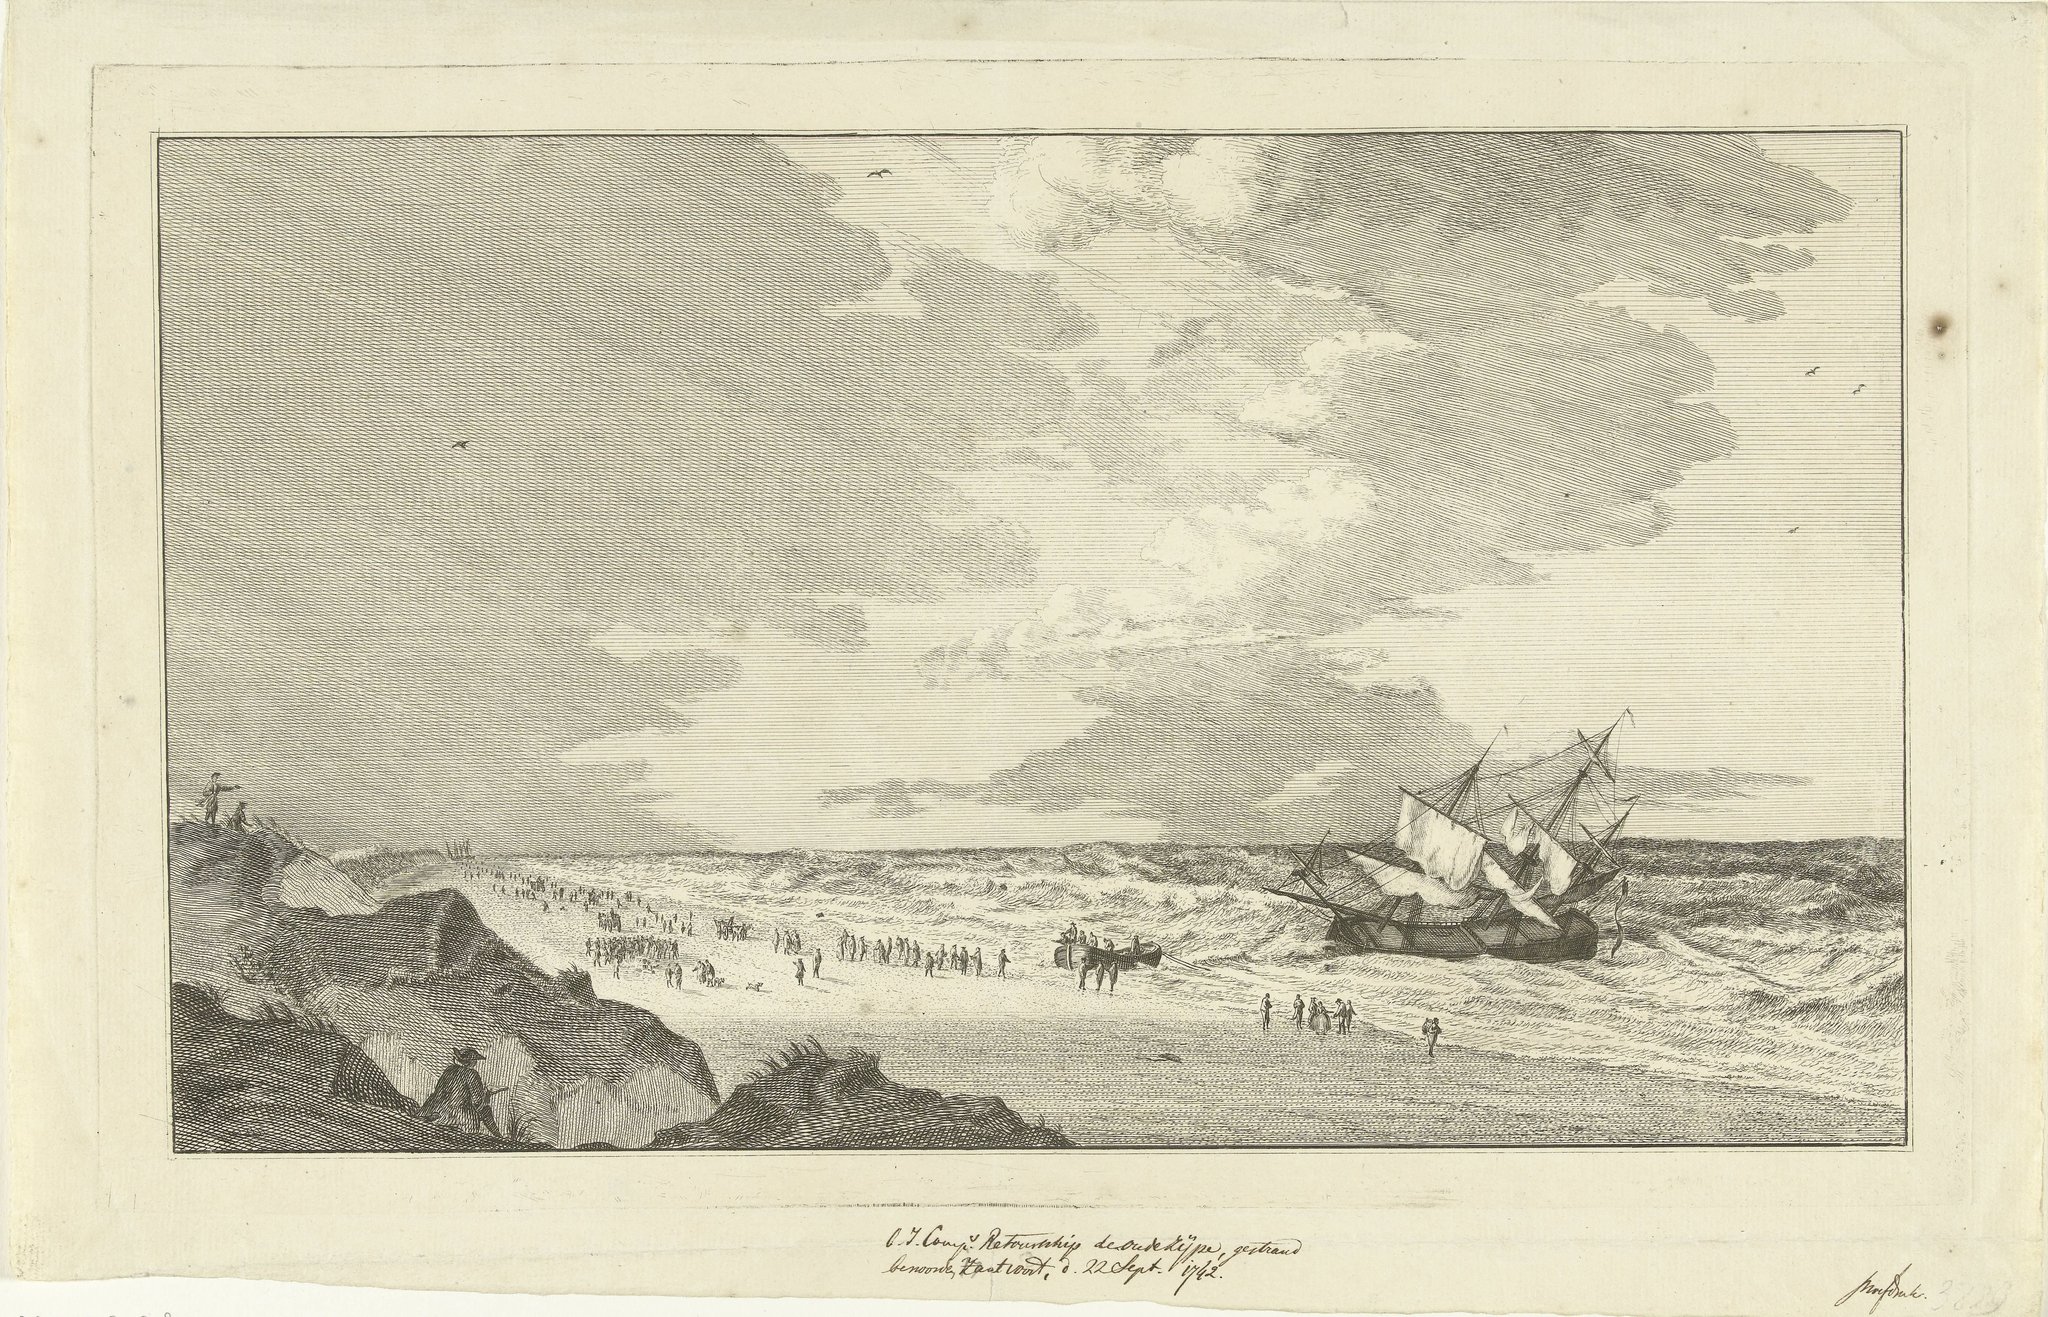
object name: print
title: Het VOC schip de Oude Zijpe gestrand bij Zandvoort, 1742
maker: Anonymous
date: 1742-1780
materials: paper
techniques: engraving, etching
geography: northern netherlands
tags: wreck ashore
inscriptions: inscription: ‘O.I. Comp. Retourschip de Oude Zijpe, gestrand benoorden Zantvoort, d. 22 Sept. 1742 / Proefdruk’, collector's mark: Lugt 2228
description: Het VOC retourschip de Oude Zijpe gestrand ten noorden van Zandvoort, 22 september 1742. Op het strand een menigte toeschouwers. Mogelijk een voorstelling van een stranding in 1780.